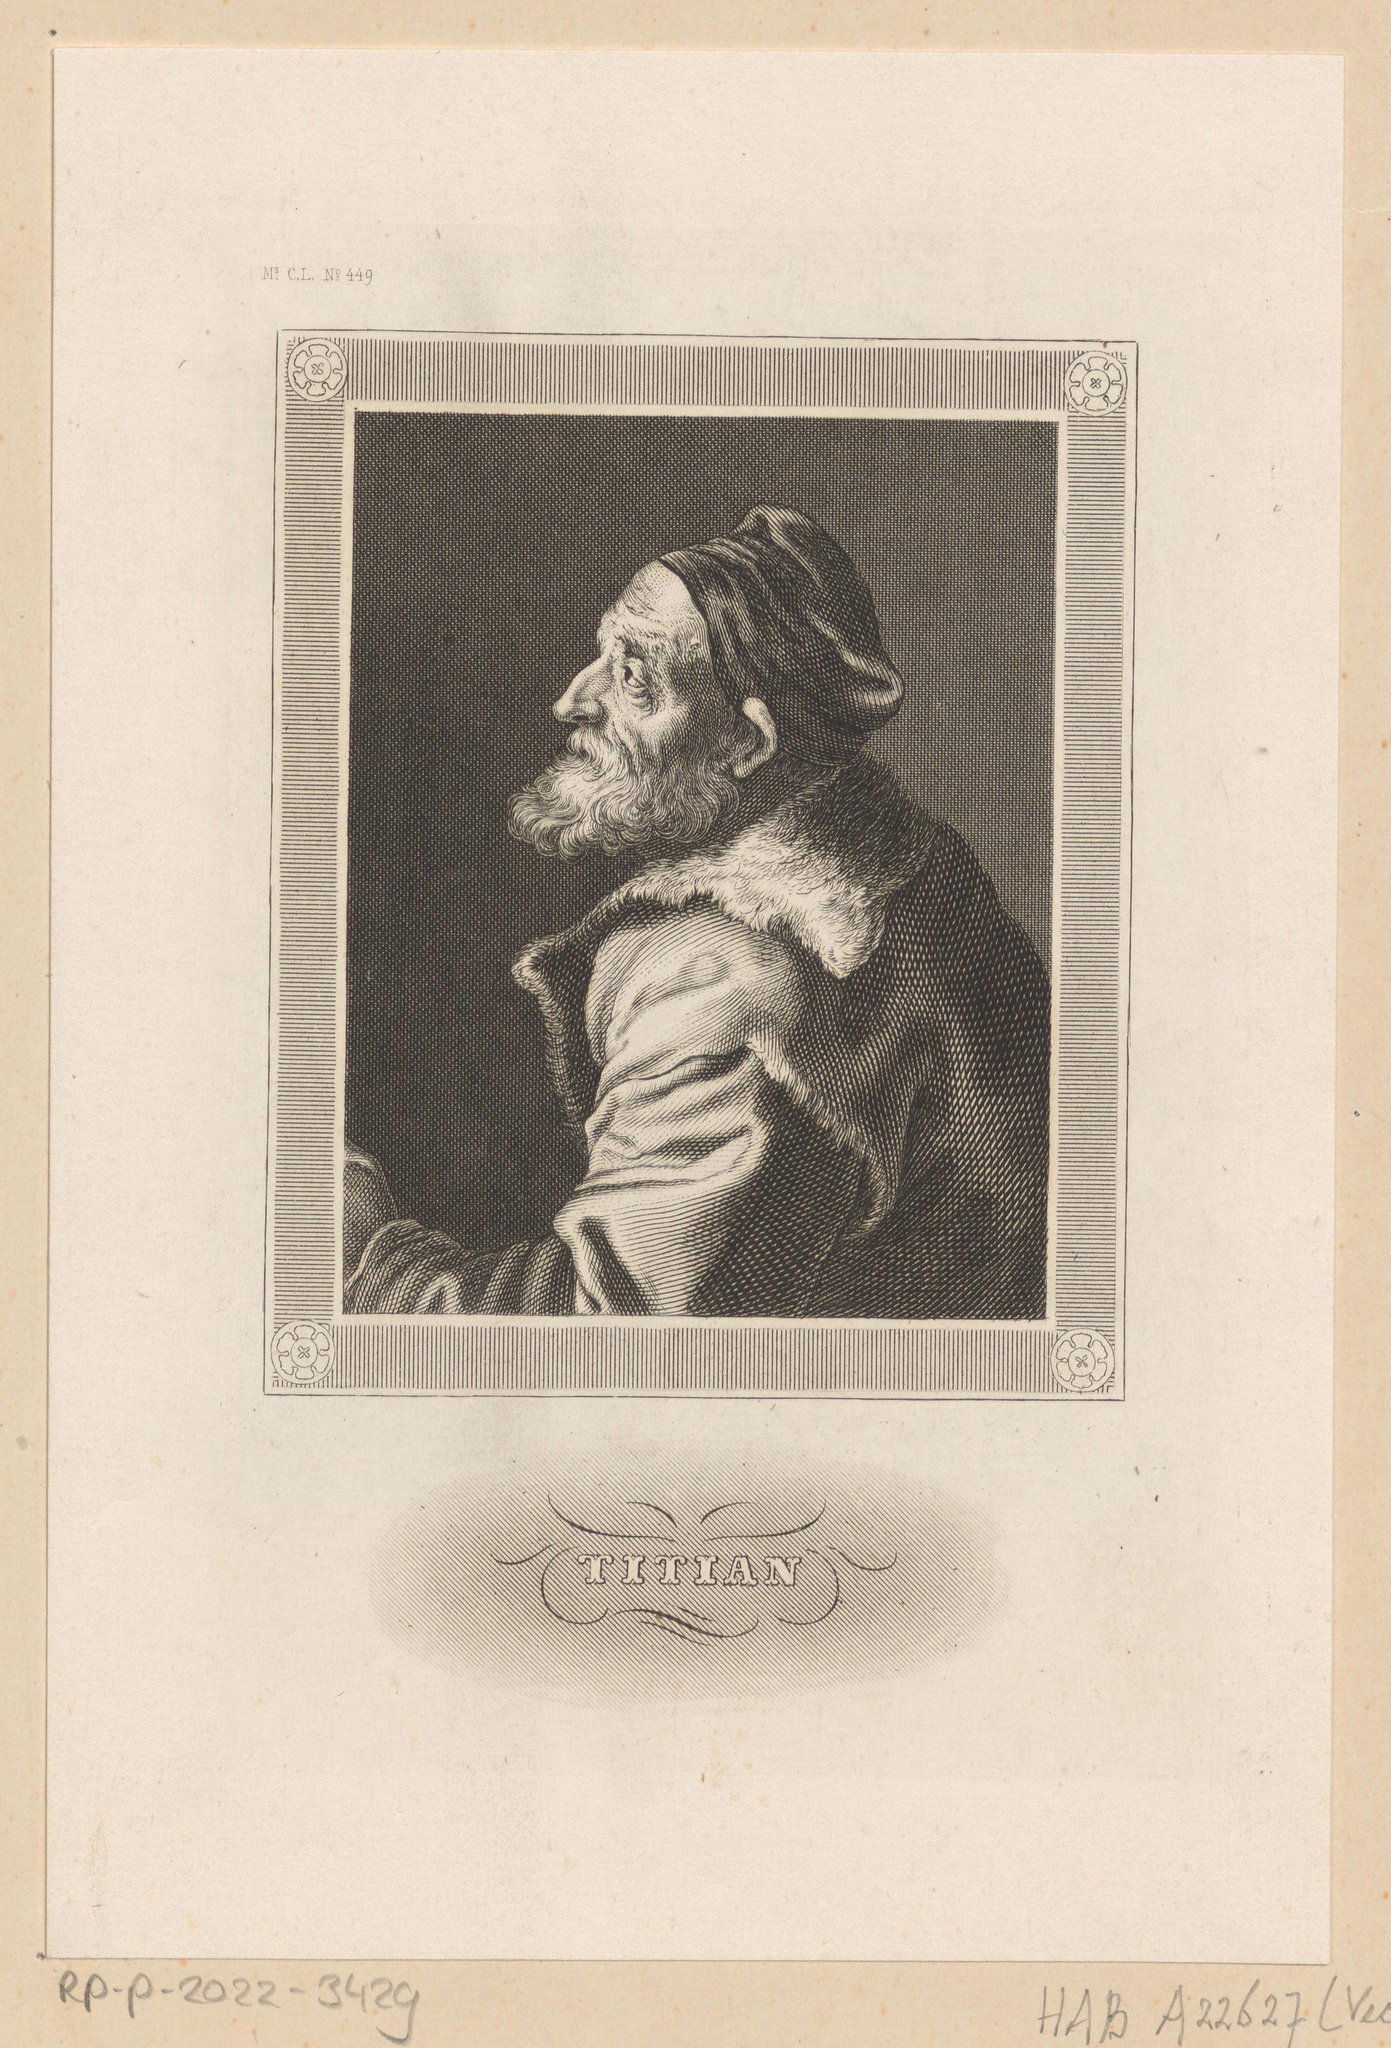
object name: print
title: Portret van Titiaan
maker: Anonymous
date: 1840-1855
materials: paper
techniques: engraving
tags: venice, painter, draughtsman, titiaan, historical persons, portrait, self-portrait of artist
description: Prent waarschijnijk uit: Meyer, Joseph, Das große Conversations-Lexikon für die gebildeten Stände. Hildburghausen: Bibliographisches Institut 1840-55, dl. 4.2.